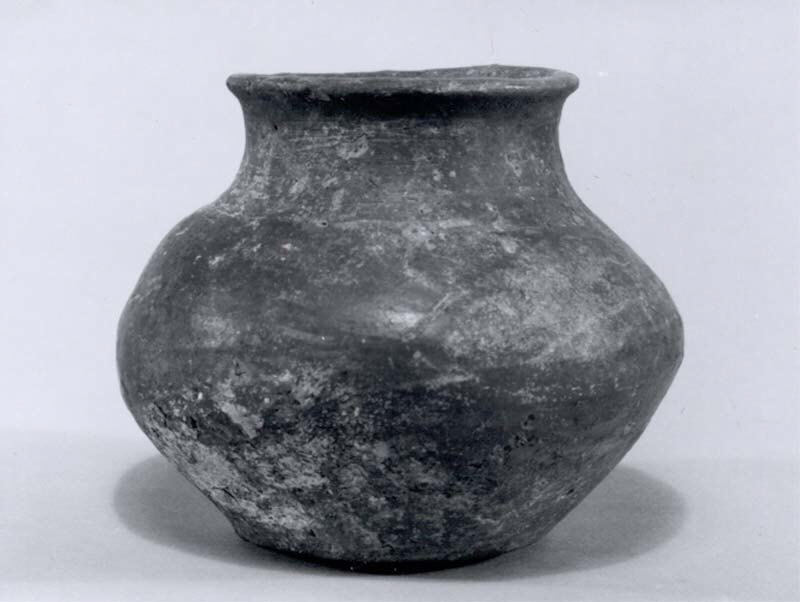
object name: jar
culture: iranian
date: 900-801 BCE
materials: ceramic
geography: iran